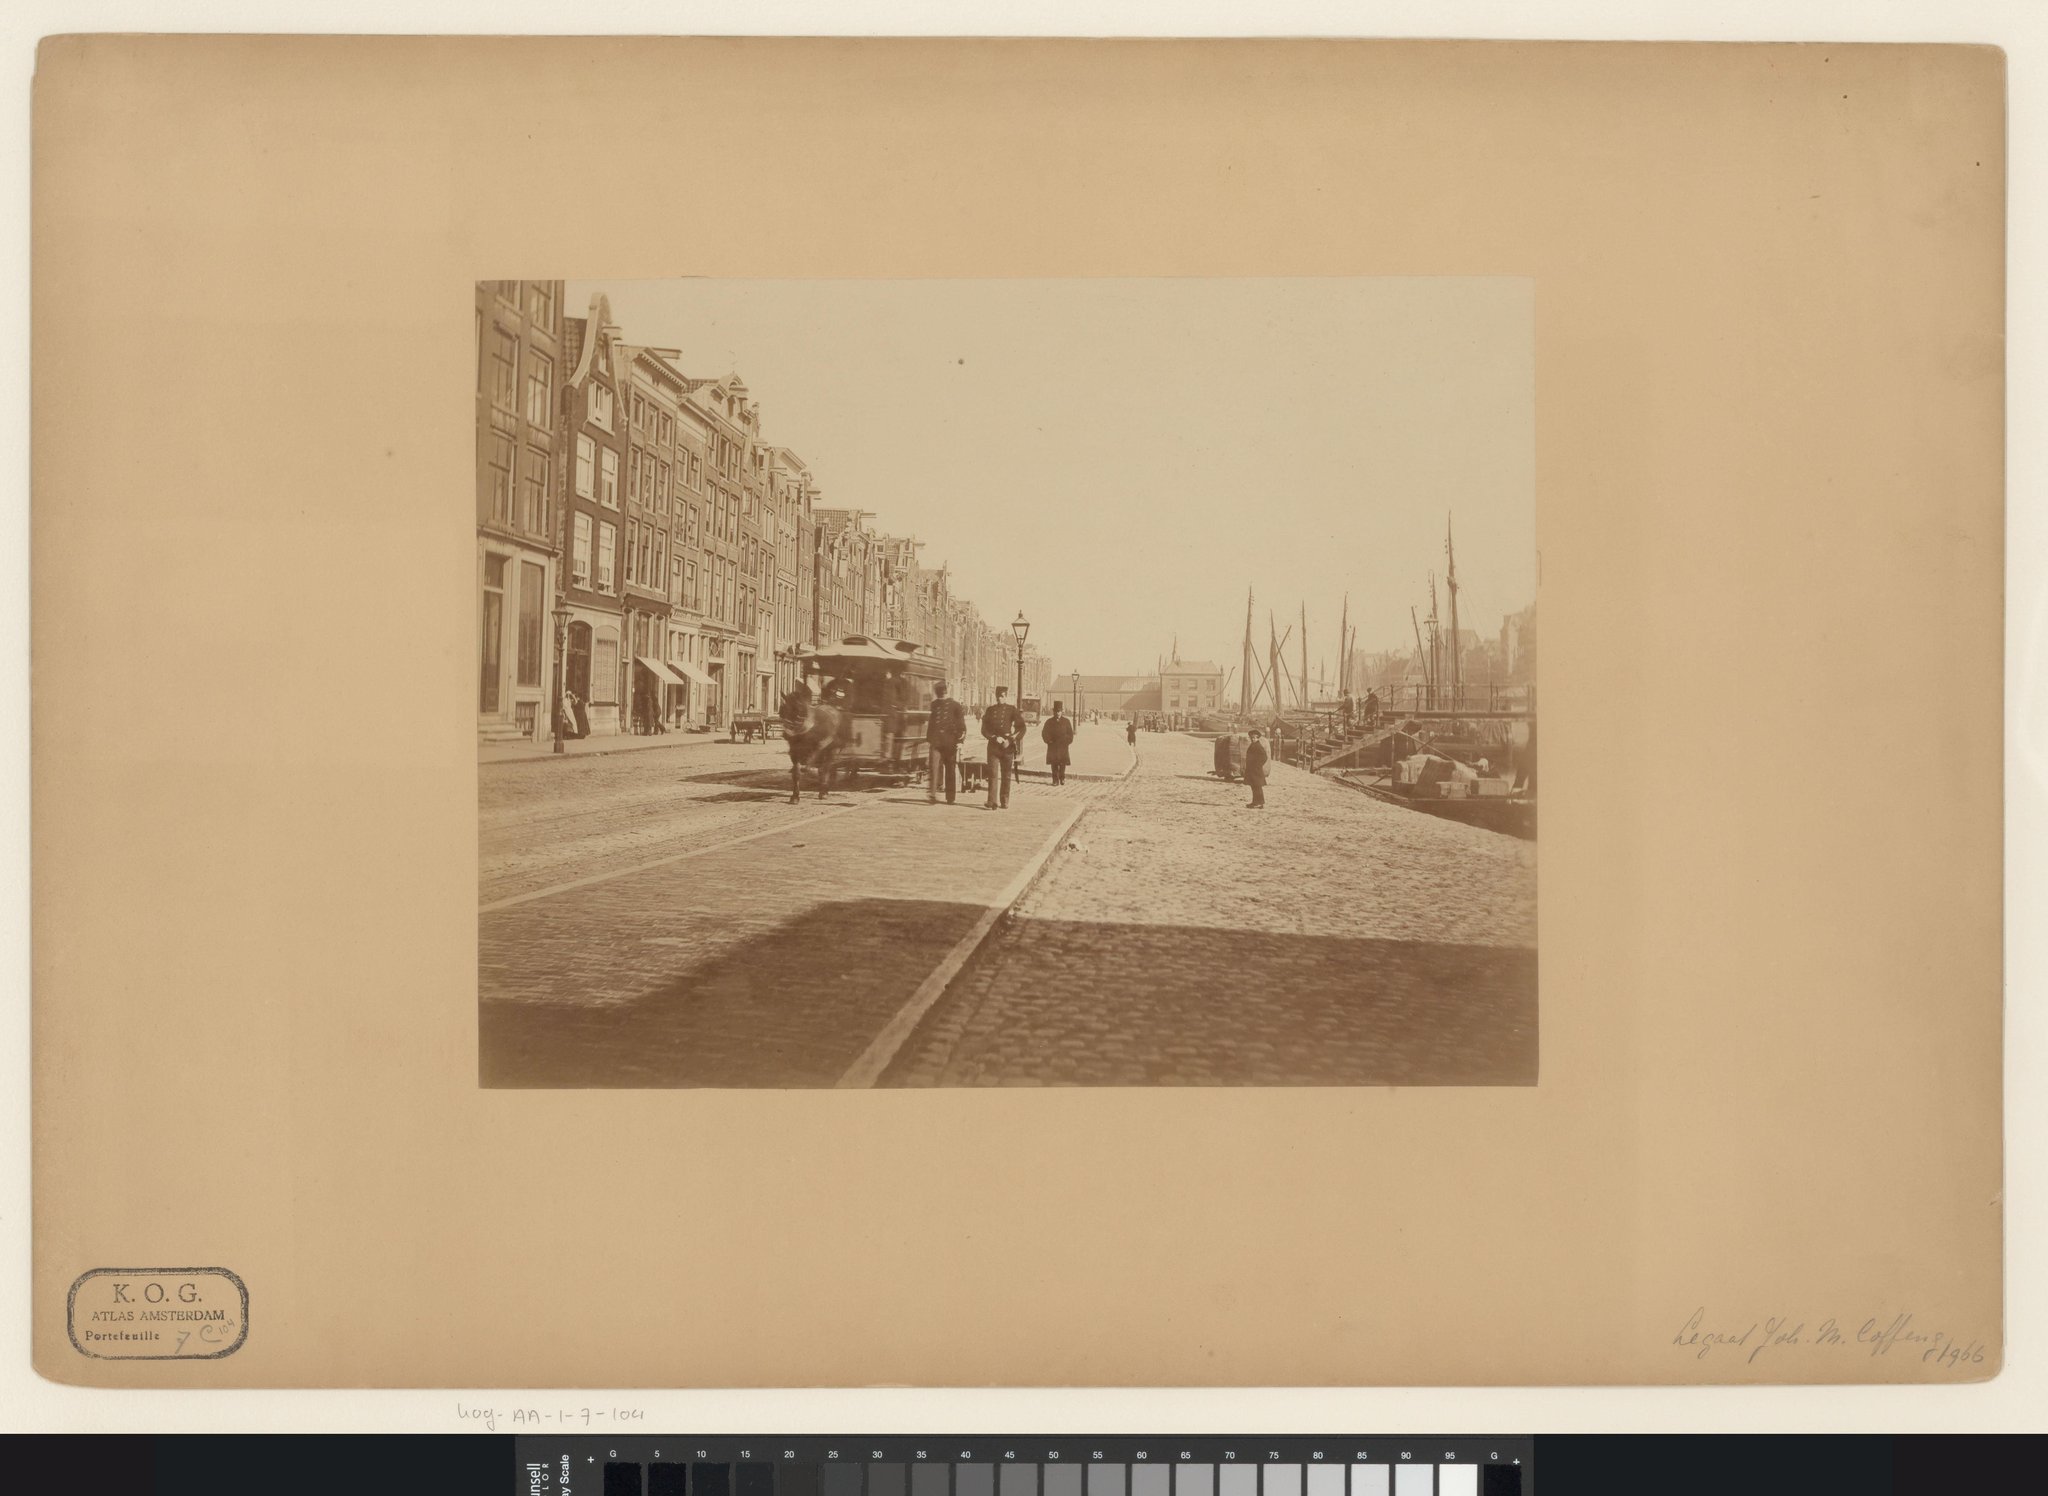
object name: photograph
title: Gezicht op het Damrak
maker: Anonymous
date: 1860-1900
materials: cardboard, paper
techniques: albumen print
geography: amsterdam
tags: diligence, omnibus, horse-tram, city-view in general; 'veduta', the usual house or row of houses, street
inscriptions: inscription: ‘Legaat Joh. M. Coffeng / 1966’, collector's mark: ‘7C’ Lugt 1641b, : ‘11. Amsterdam. / Het Damrak.’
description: Onderwerpsrubriek binnen de Atlas Amsterdam: Damrak, Damstraat, Doelensluis, Doelenstraat (Nieuwe), Driehoekstraat, Droogbak, Duvelshoek, Dijkstraat en Korte -.